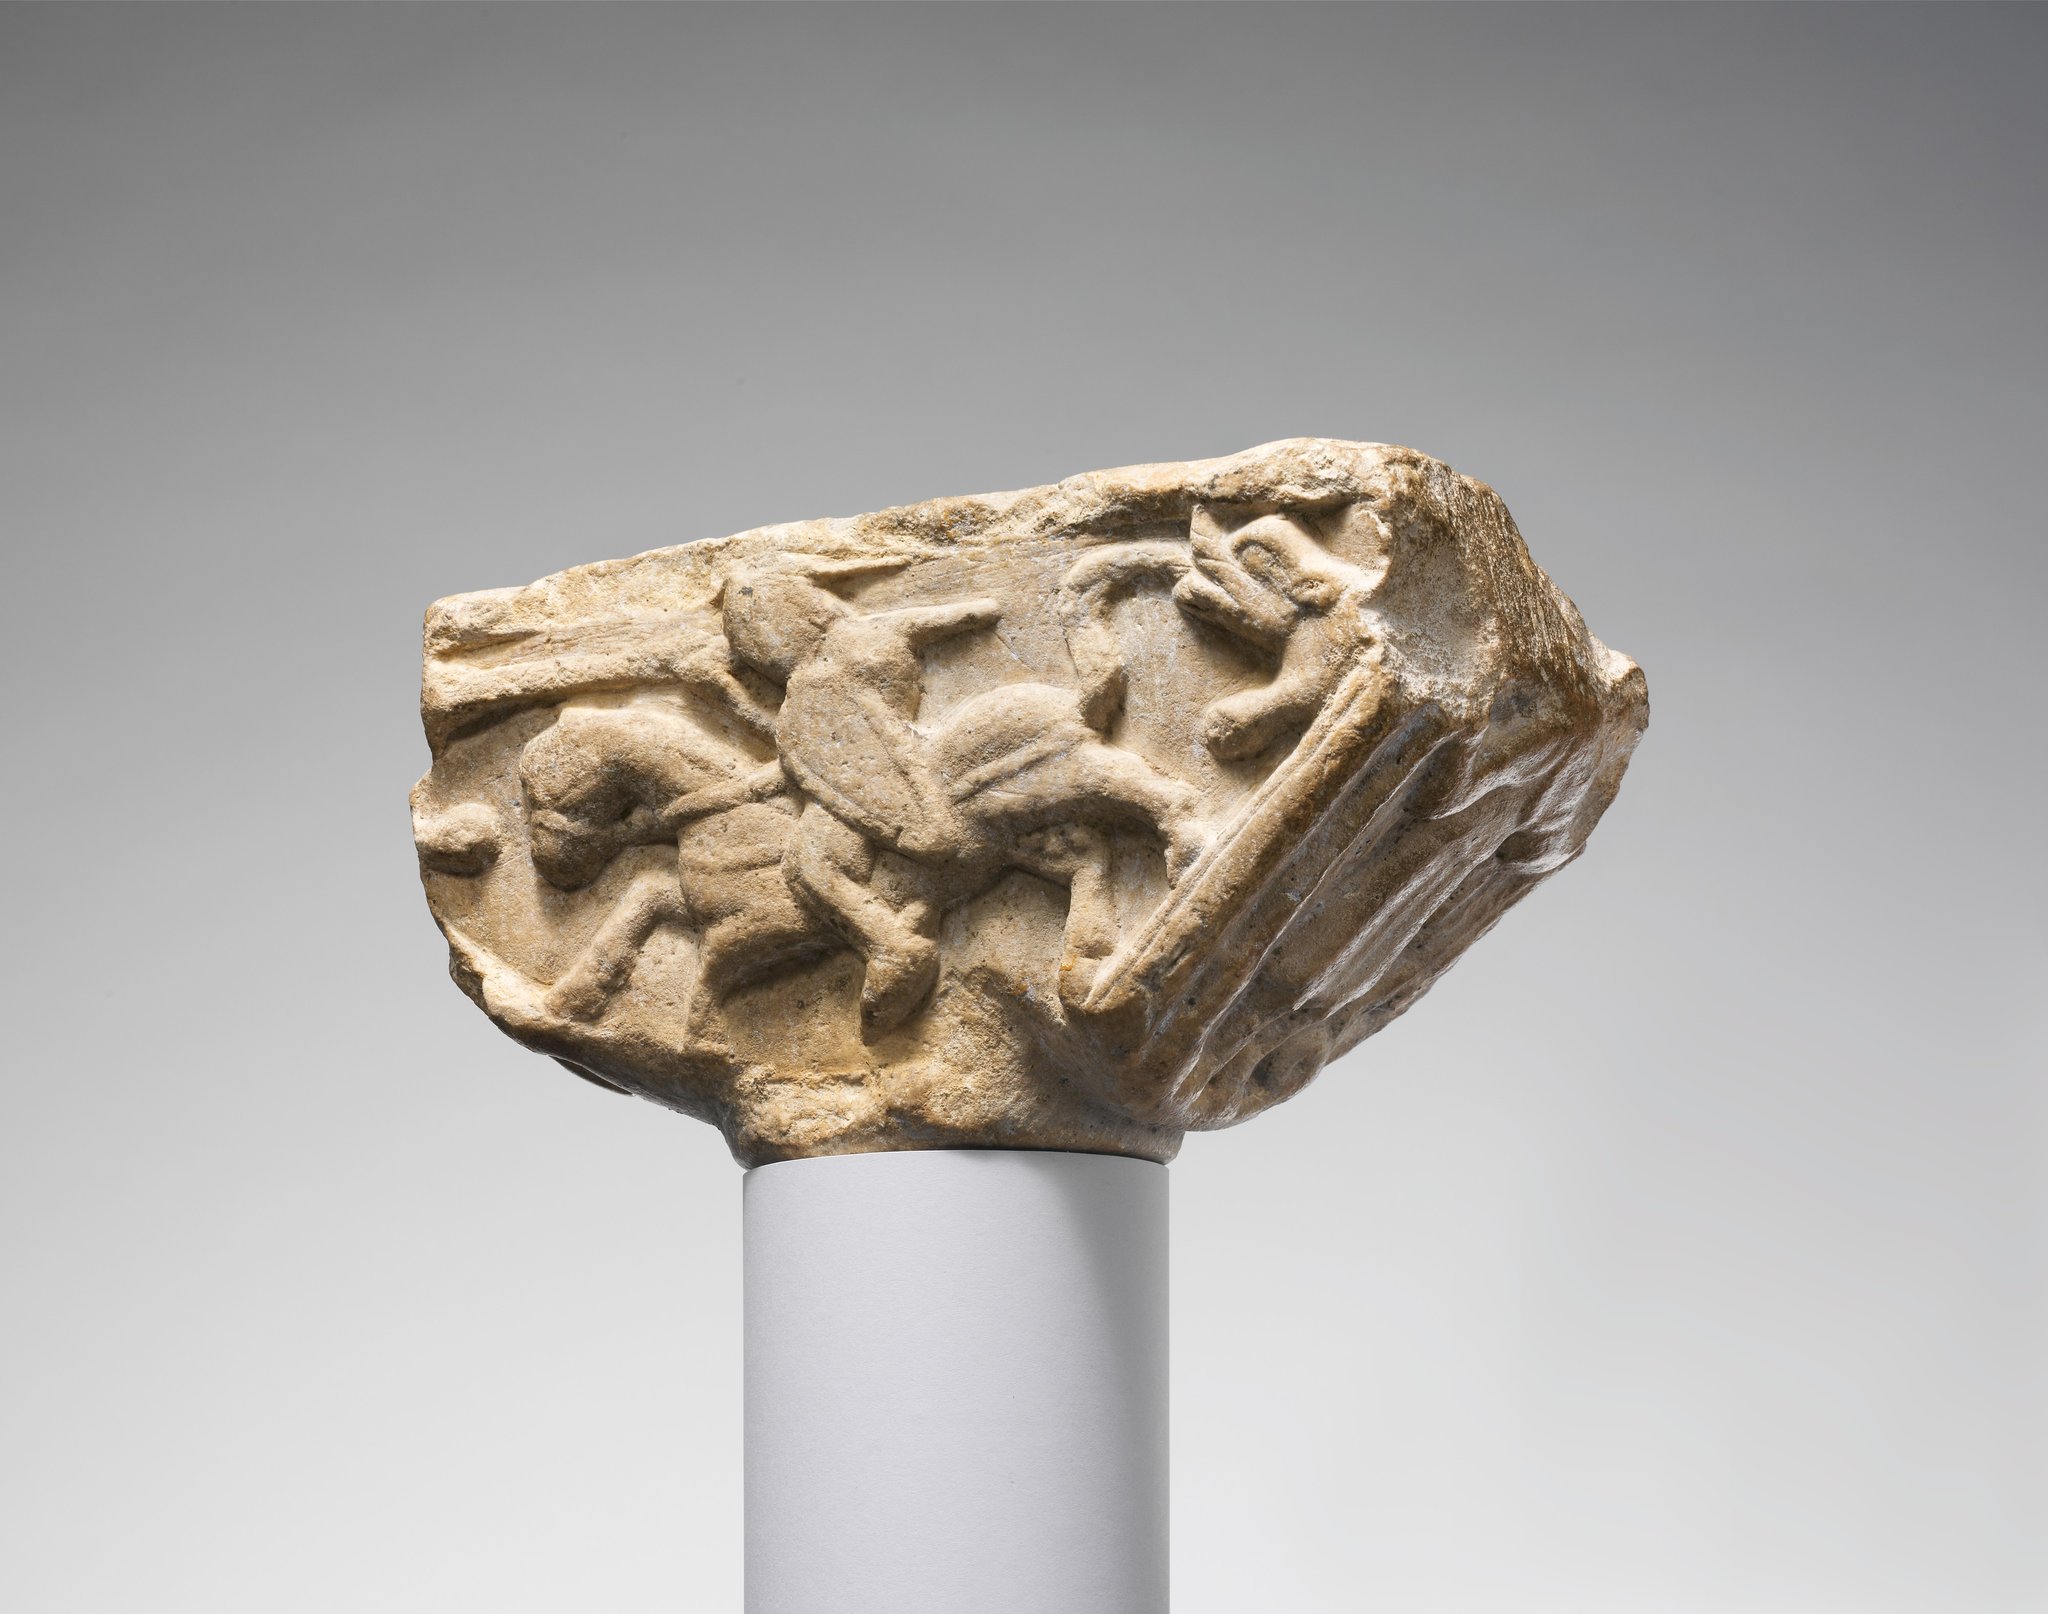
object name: column capital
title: Capital of a Column with an Armored Knight on Each Side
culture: italian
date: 1100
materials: marble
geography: italy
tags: horses,knights